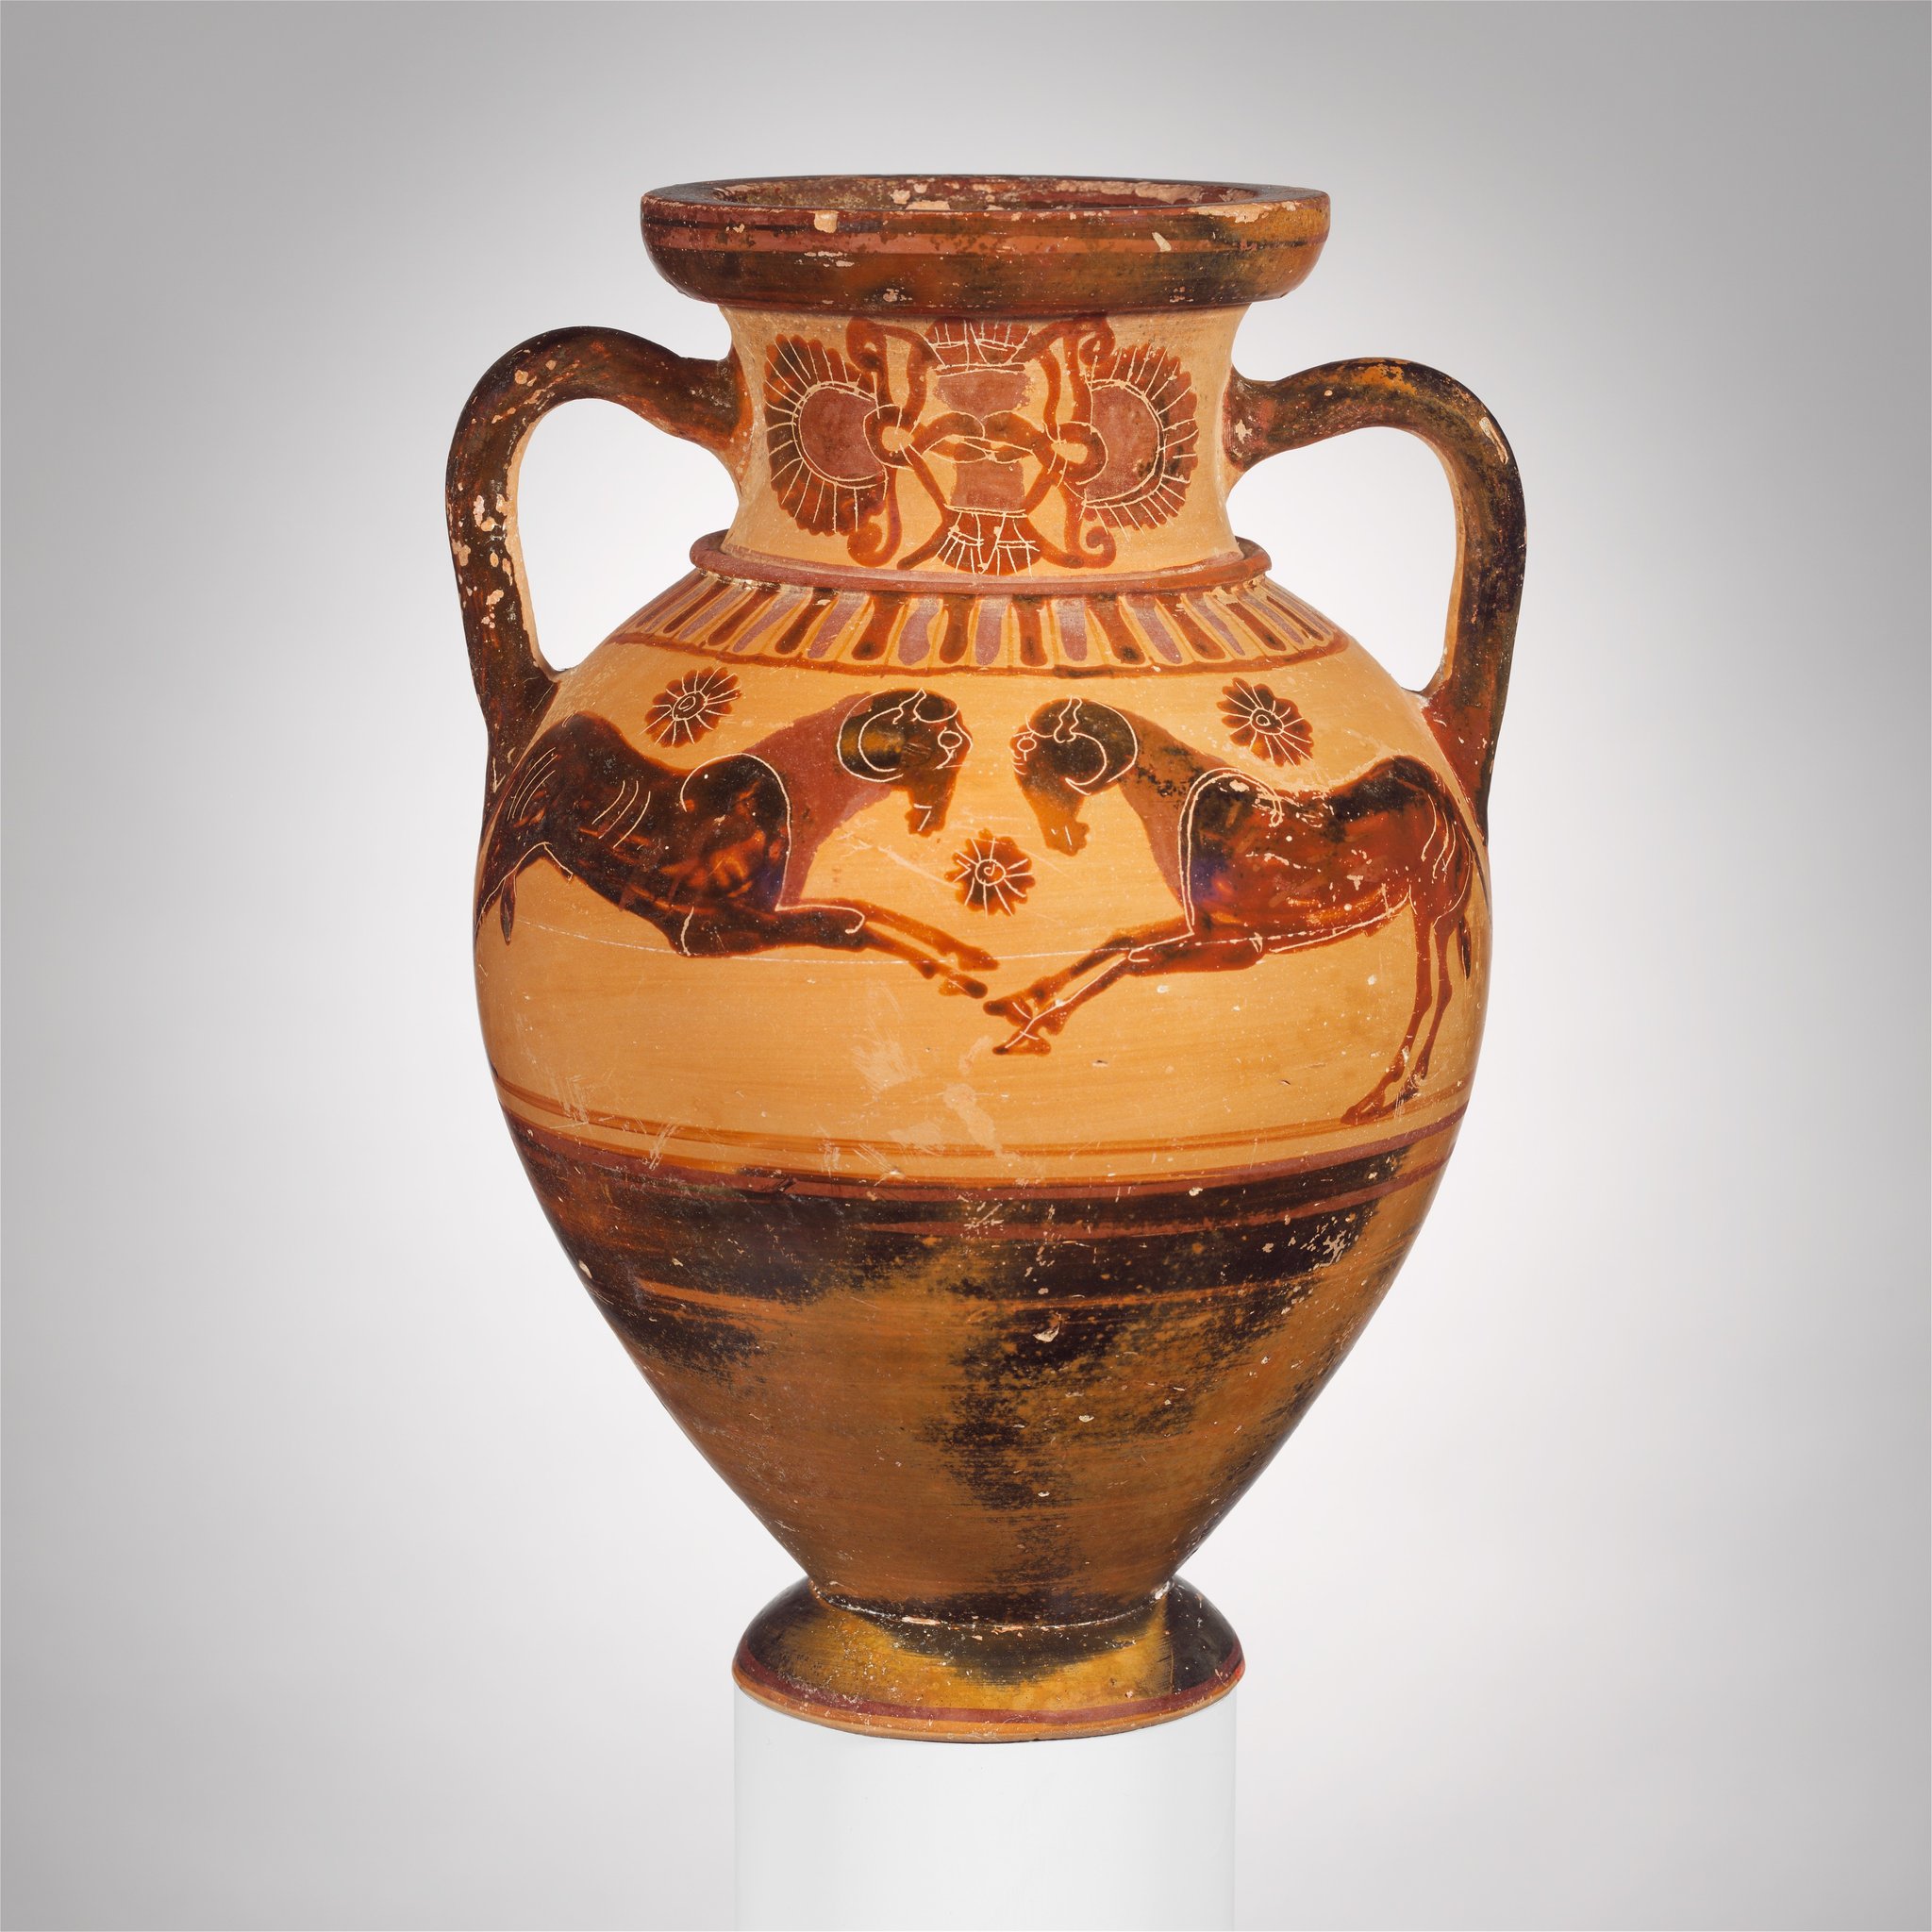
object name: neck amphora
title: Terracotta neck-amphora (storage jar)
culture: greek, attic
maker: prometheus painter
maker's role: artist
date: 570-560 BCE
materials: terracotta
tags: men,roosters,rams